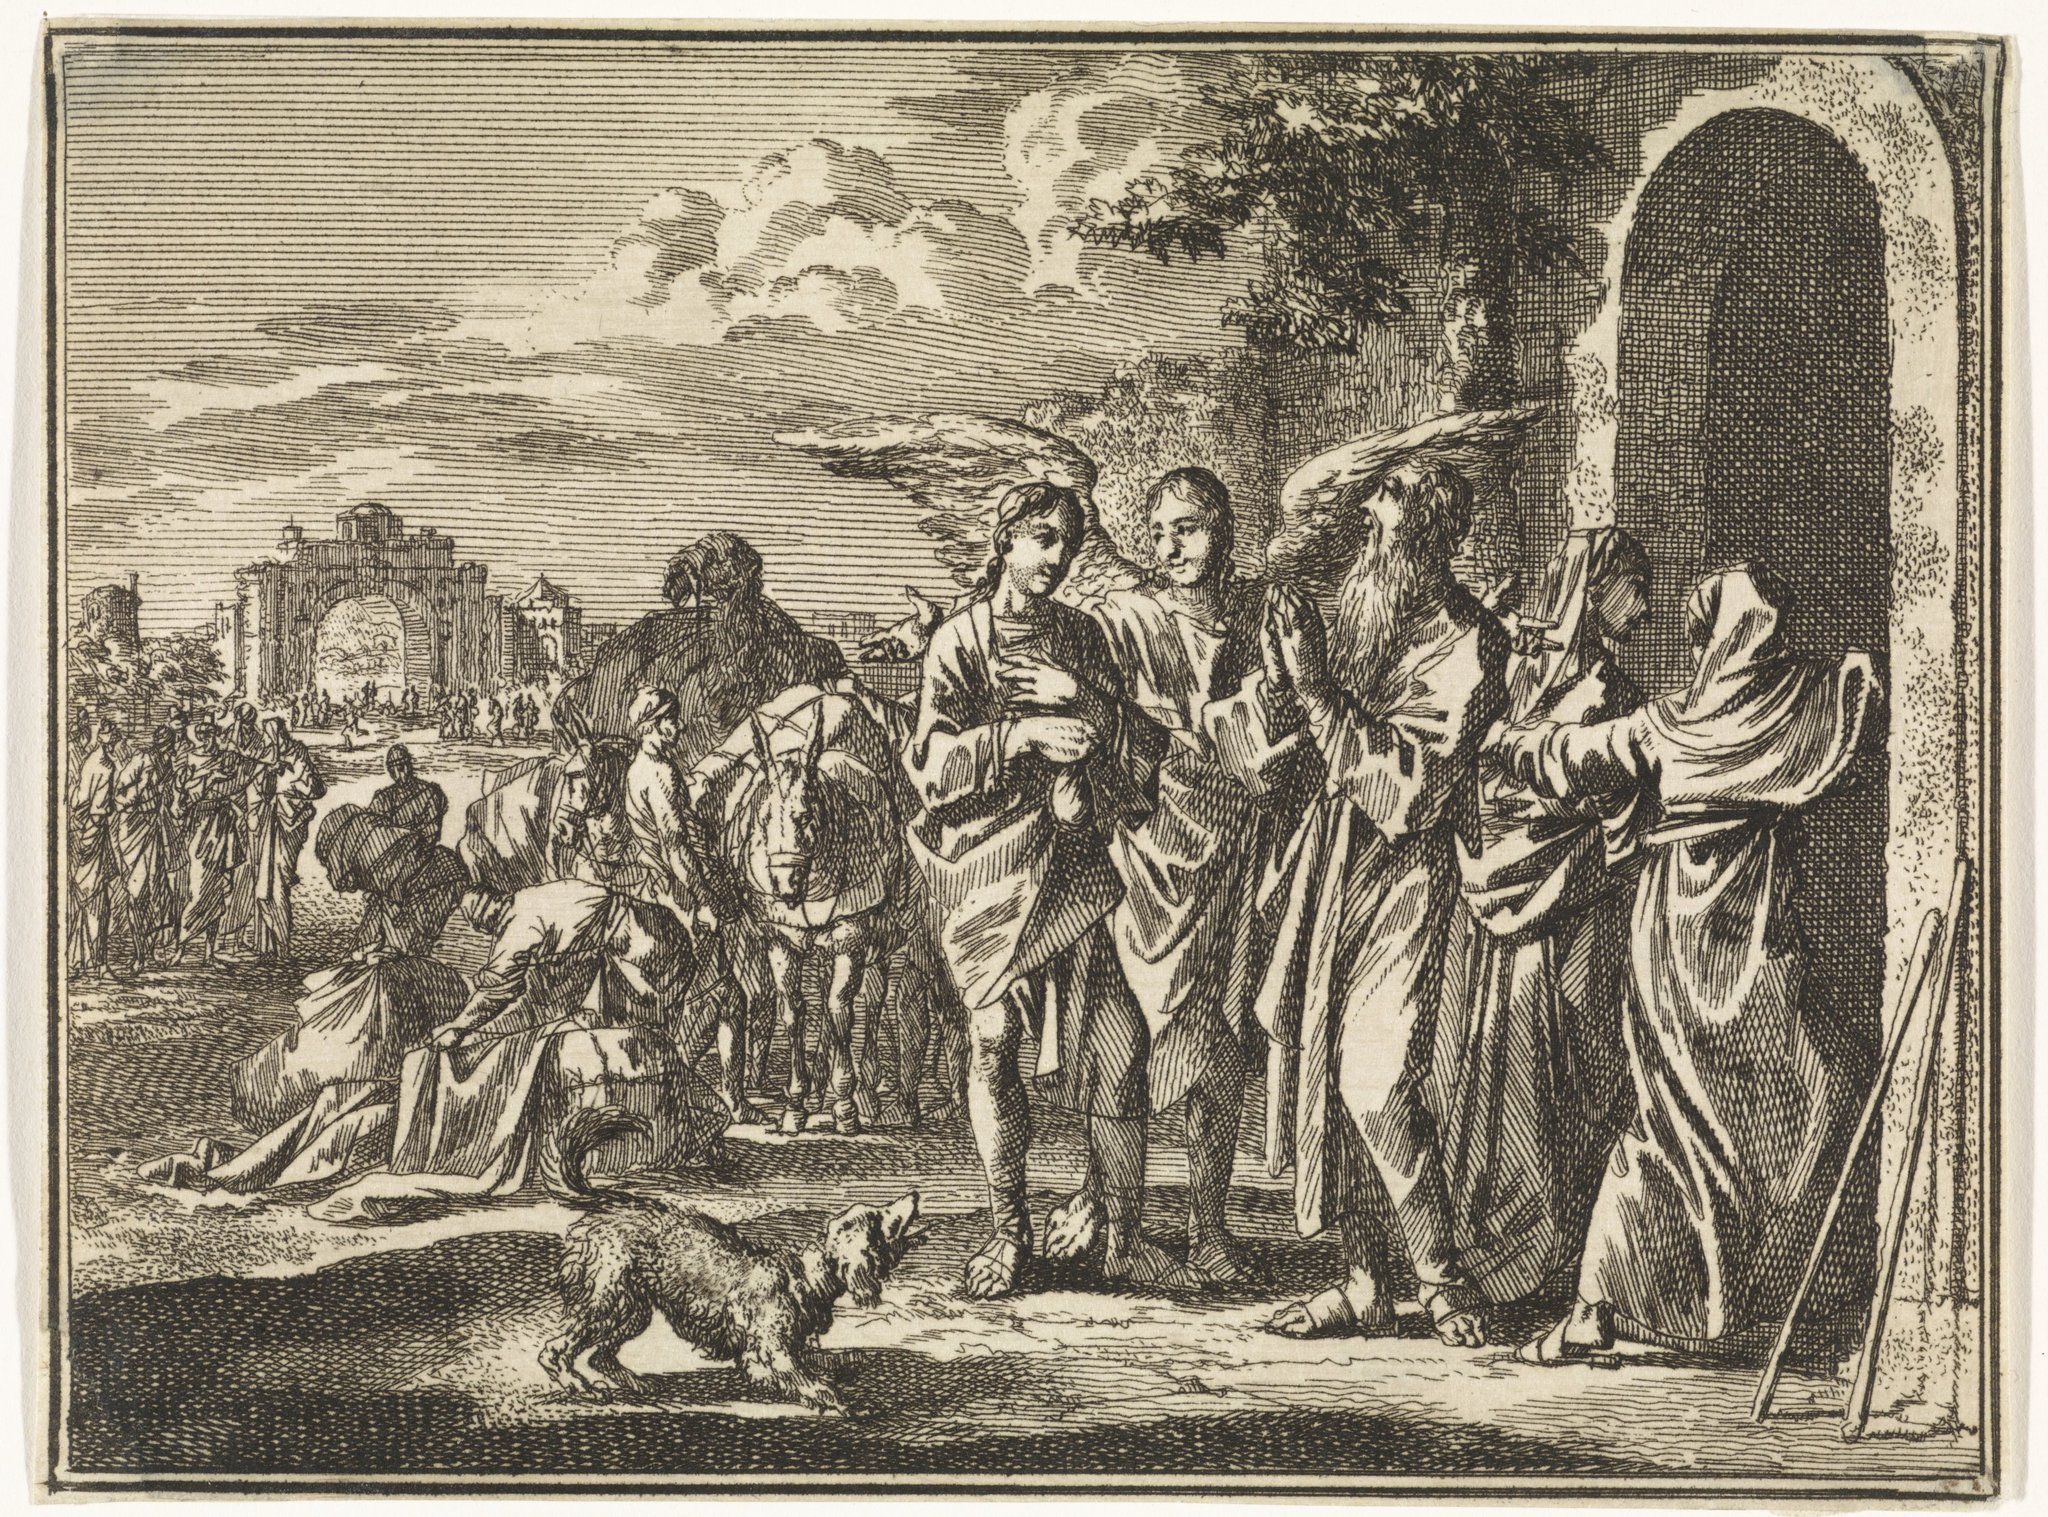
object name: print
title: Tobit dankt God voor de genezing van zijn blindheid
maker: jan luyken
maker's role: draughtsman, print maker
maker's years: 1649-1712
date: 1712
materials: paper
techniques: etching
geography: amsterdam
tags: sarah's arrival ~ tobias' return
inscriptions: number: ‘179’, collector's mark: Lugt 2228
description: Illustratie uit: Luyken, Jan. De schriftuurlyke geschiedenissen en gelykenissen van het Oude en Nieuwe Verbond, 2 delen. Amsterdam: Wed. Pieter Arentsz II en Cornelis van der Sys, 1712, dl. I.